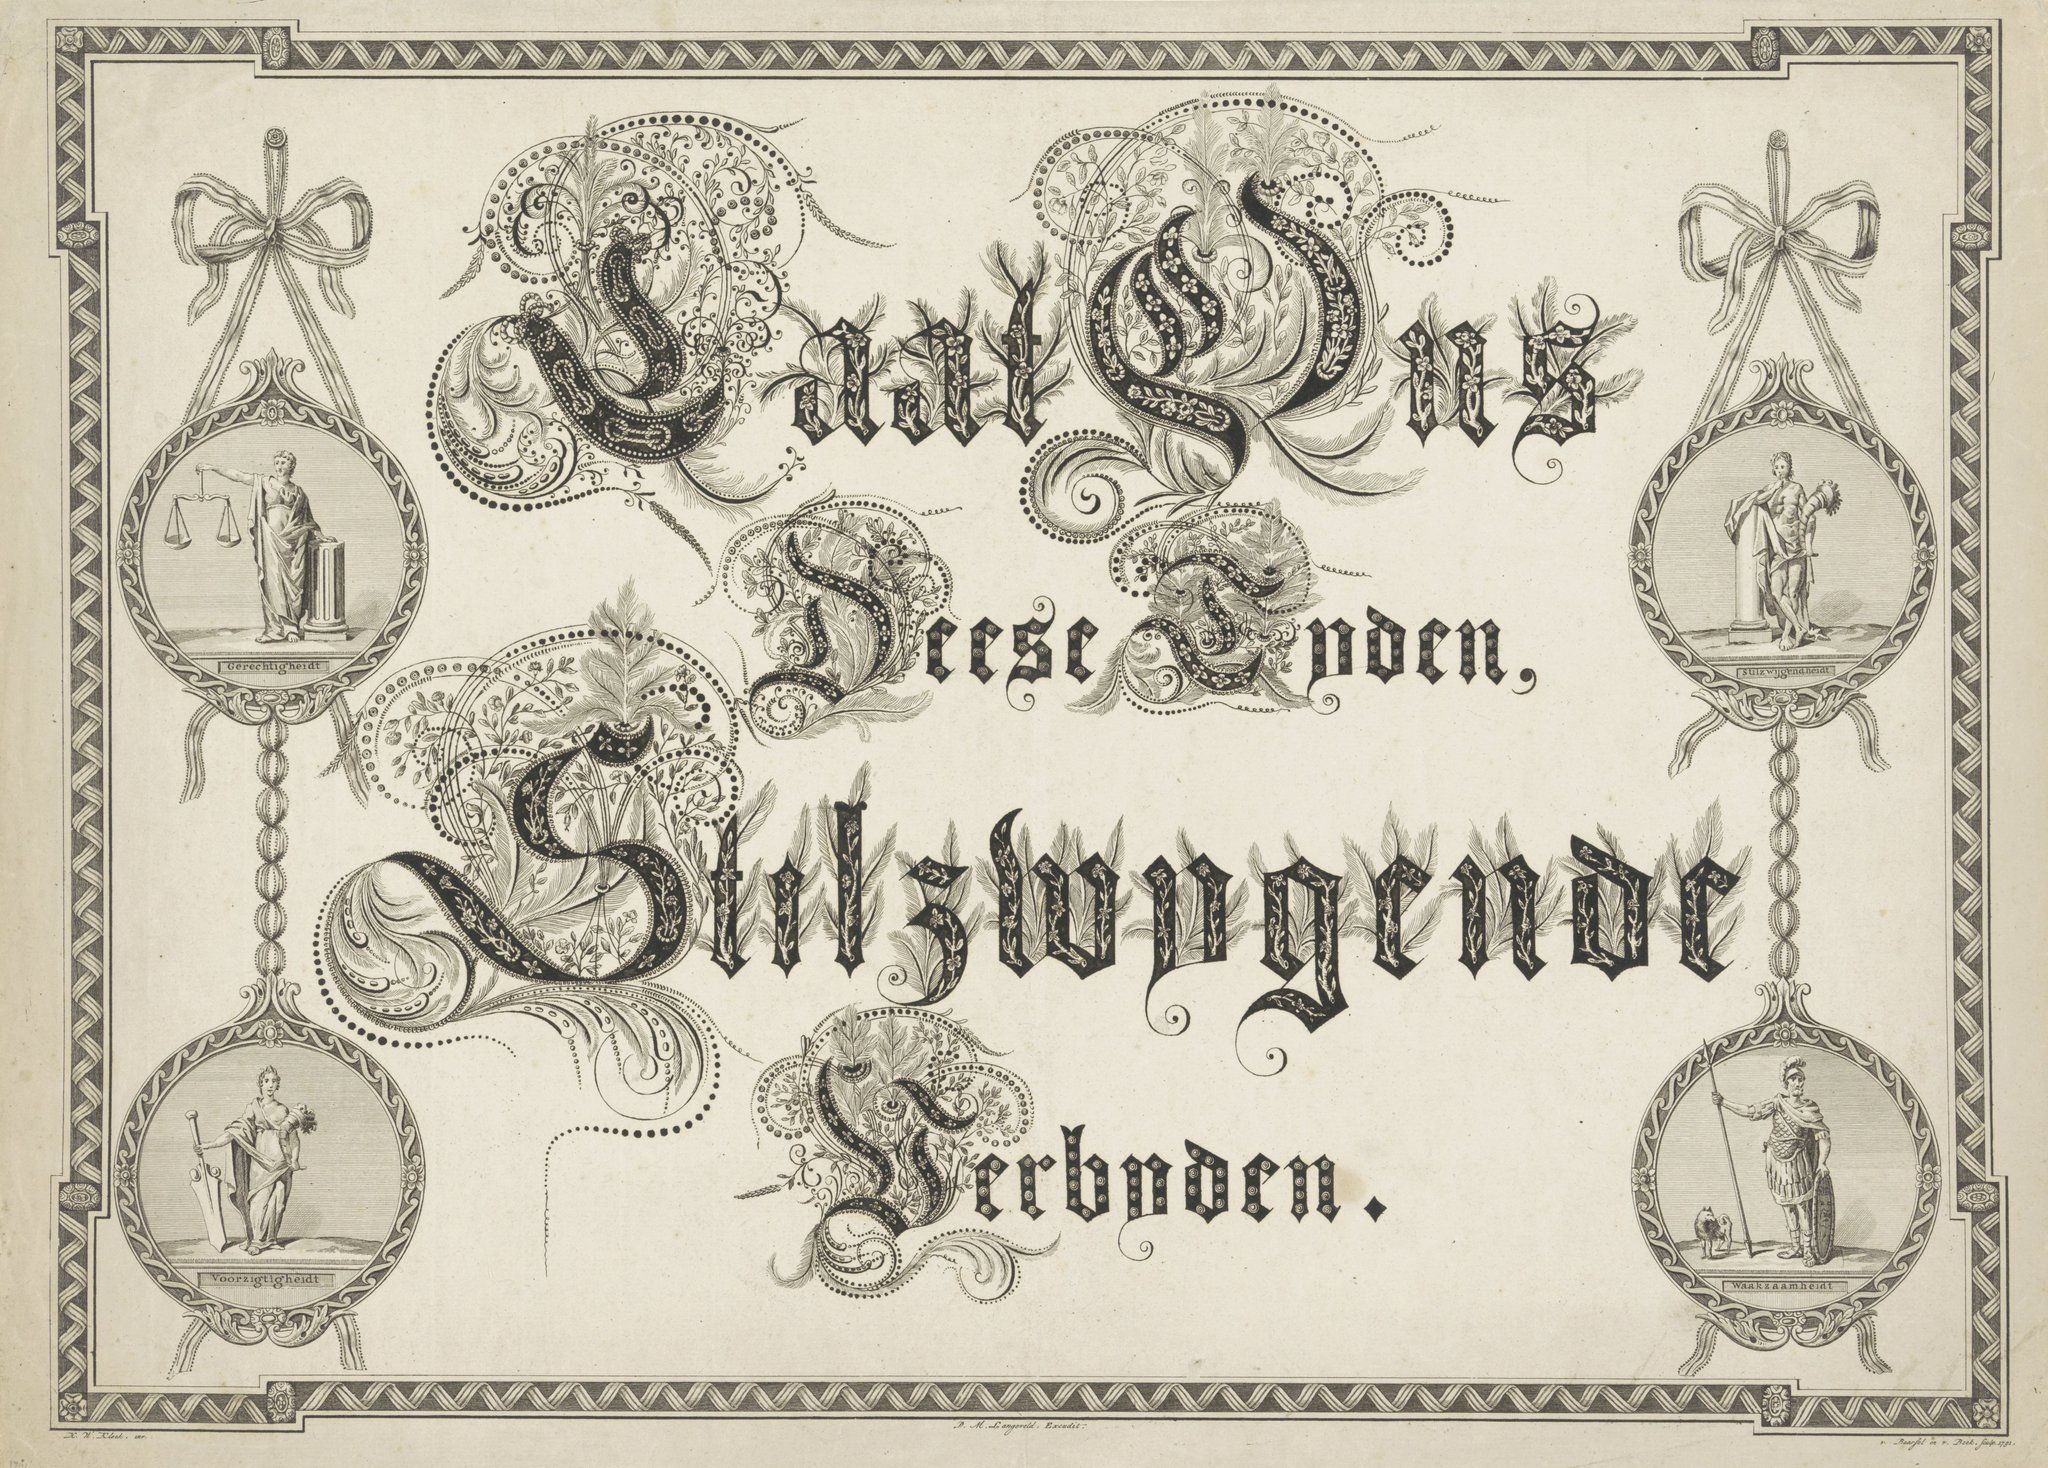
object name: print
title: Kalligrafie op de afwachtende houding van de Patriotten, 1791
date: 1791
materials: paper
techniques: etching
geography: amsterdam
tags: justice, 'justitia'; 'giustitia divina' (ripa) ~ one of the four cardinal virtues, prudence, 'prudentia'; 'prudenza' (ripa) ~ one of the four cardinal virtues, putting a finger to the lips, 'silentium'; 'silentio' (ripa), calligraphy, alertness, vigilance; 'guardia', 'vigilanza', 'vigilanza per difendersi & oppugnare altri' (ripa), patriots (1780-1795)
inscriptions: collector's mark: Lugt 2228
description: Kalligrafie op de afwachtende houding van de Patriotten in 1791. Opschrift in kalligrafie met vier medaillons met de personificaties van Gerechtigheid, Voorzichtigheid, Stilzwijgendheid en Waakzaamheid (met keeshond).